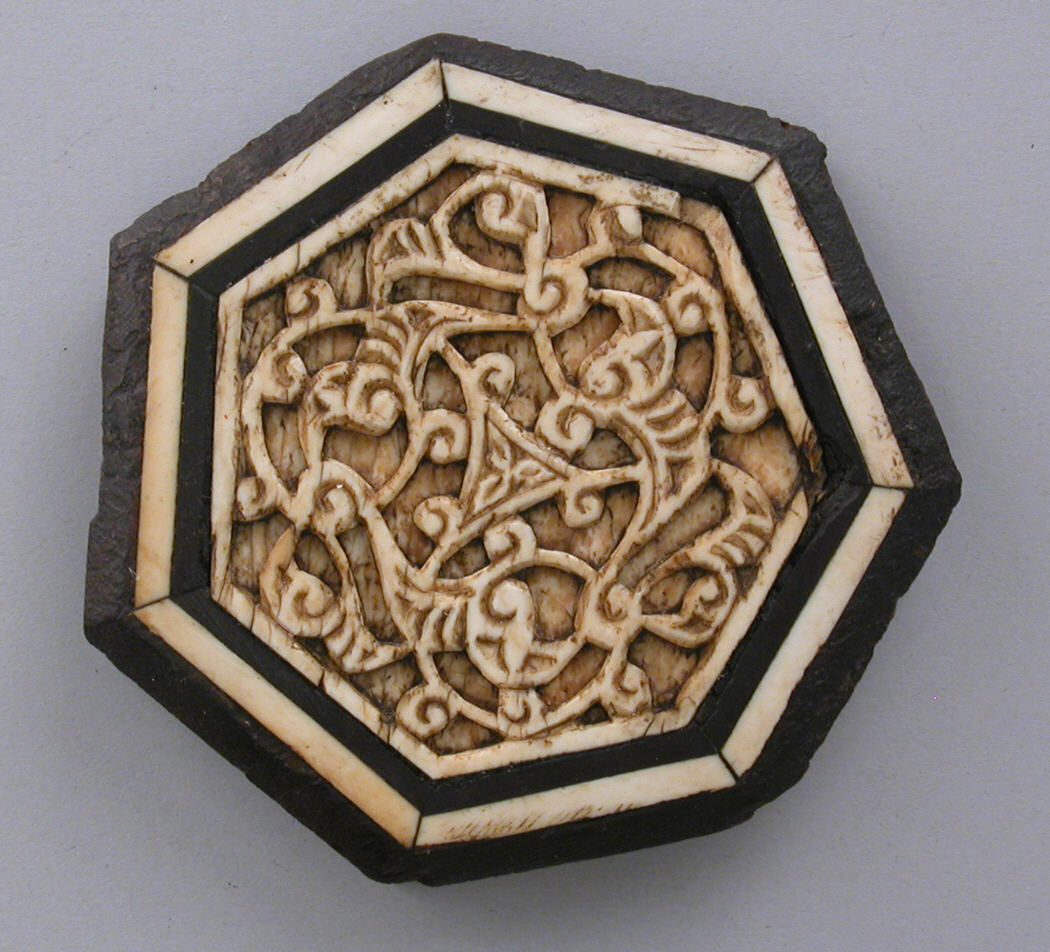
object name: panel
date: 1201-1400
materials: ivory, wood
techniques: carving, inlay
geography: egypt